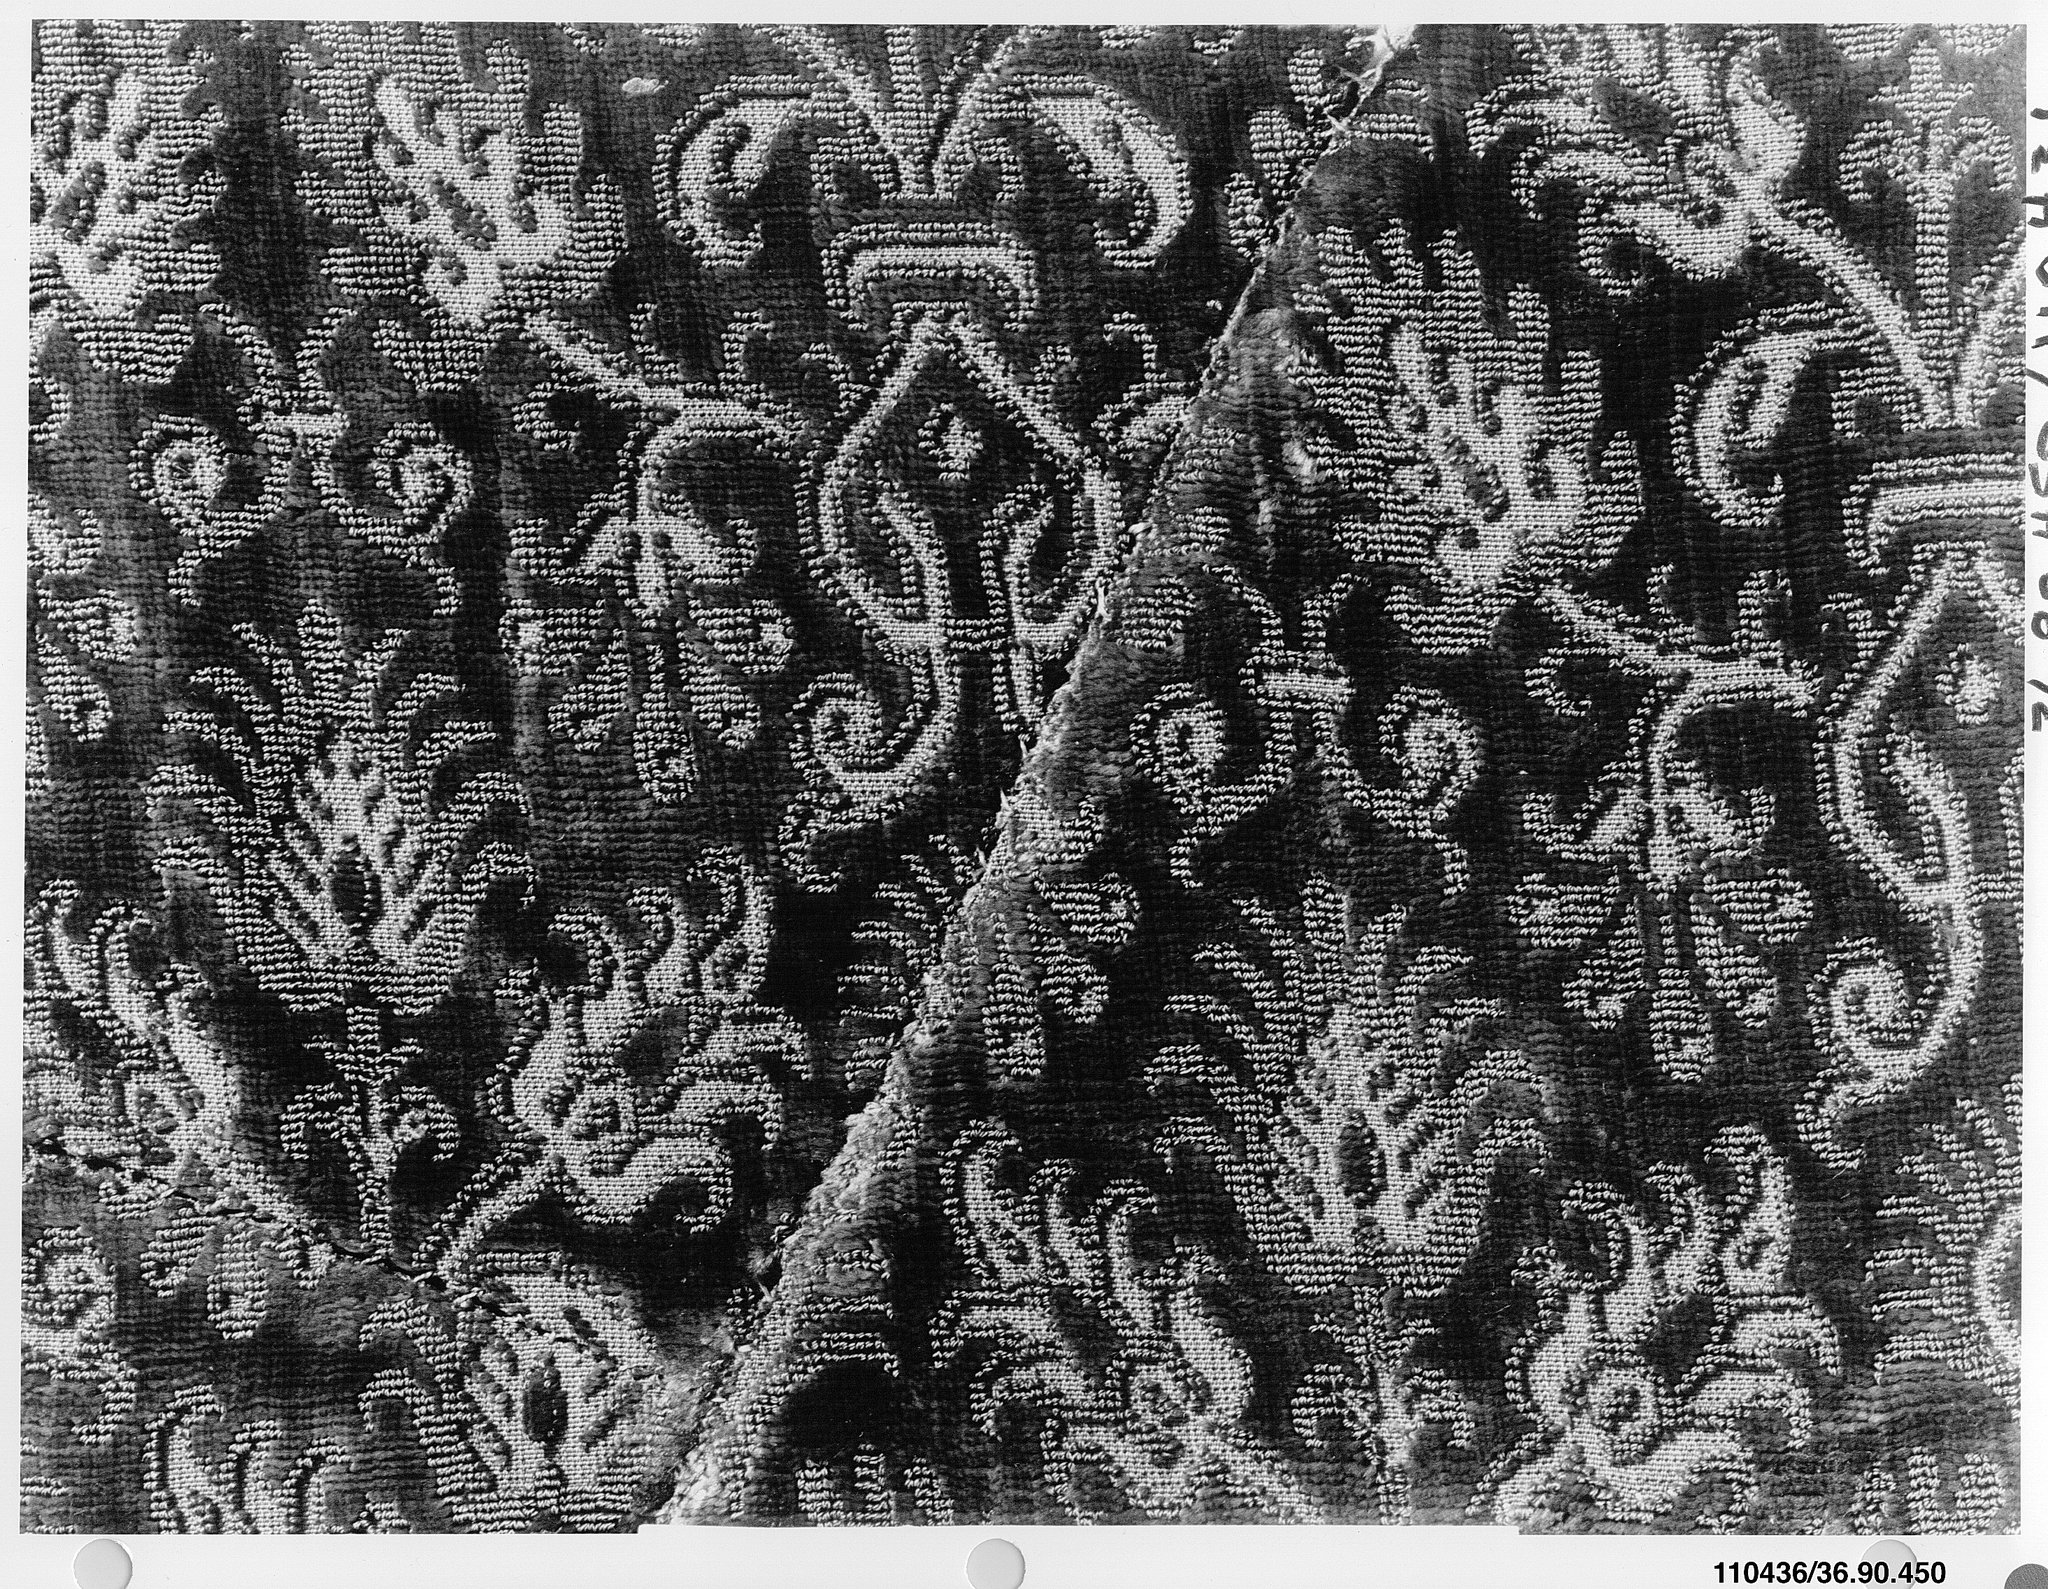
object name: piece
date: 1501-1700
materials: silk